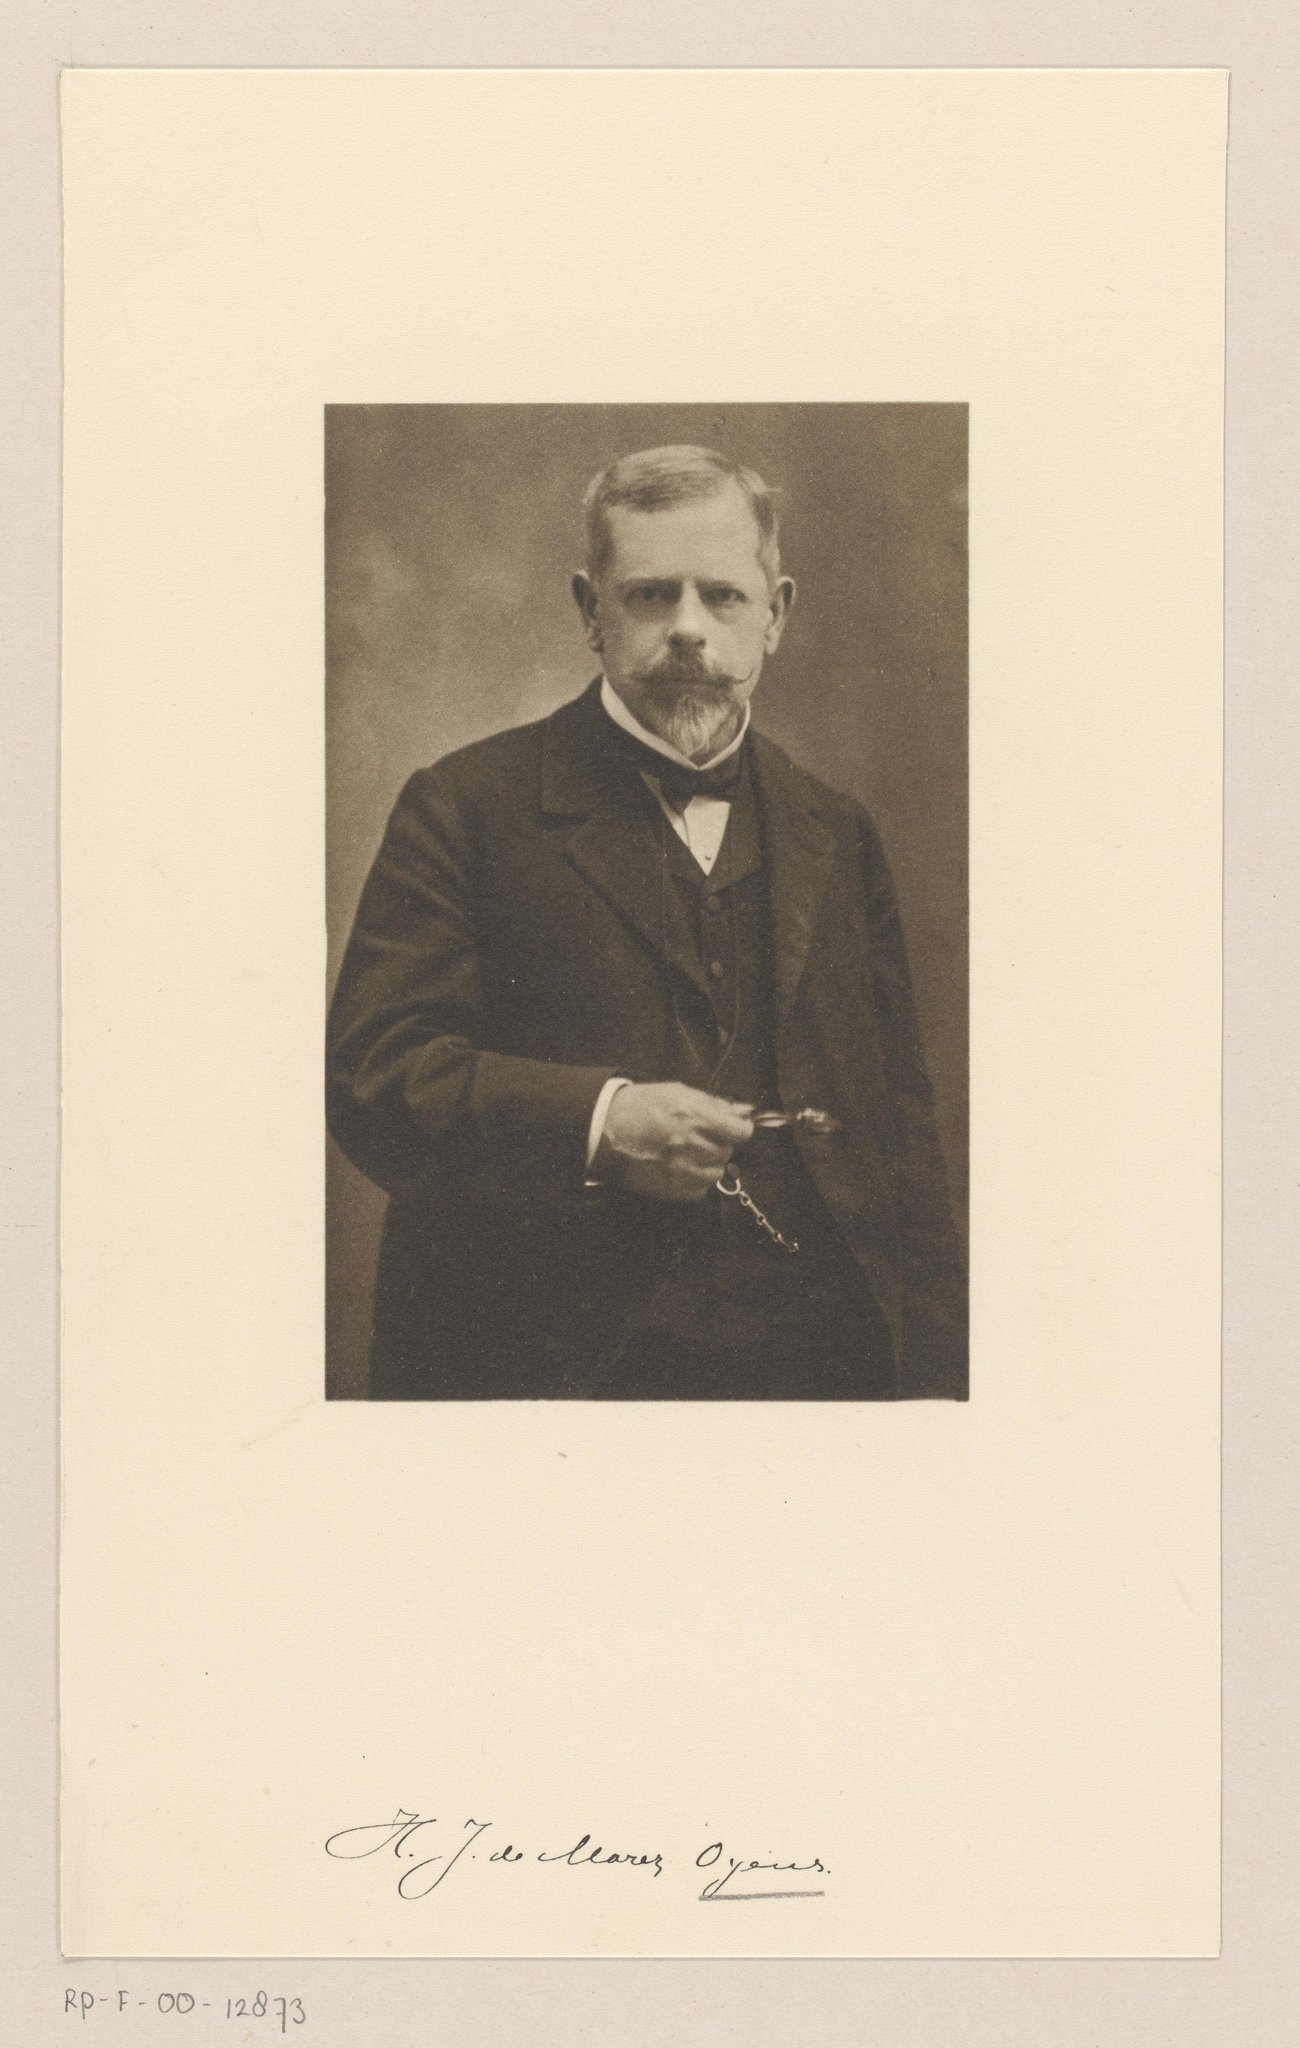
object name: photomechanical print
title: Portret van Hendrik Jan de Marez Oyens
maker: Anonymous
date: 1910-1930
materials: paper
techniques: photograph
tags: historical persons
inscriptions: inscription: ‘H.J. de Morez Oyens.’